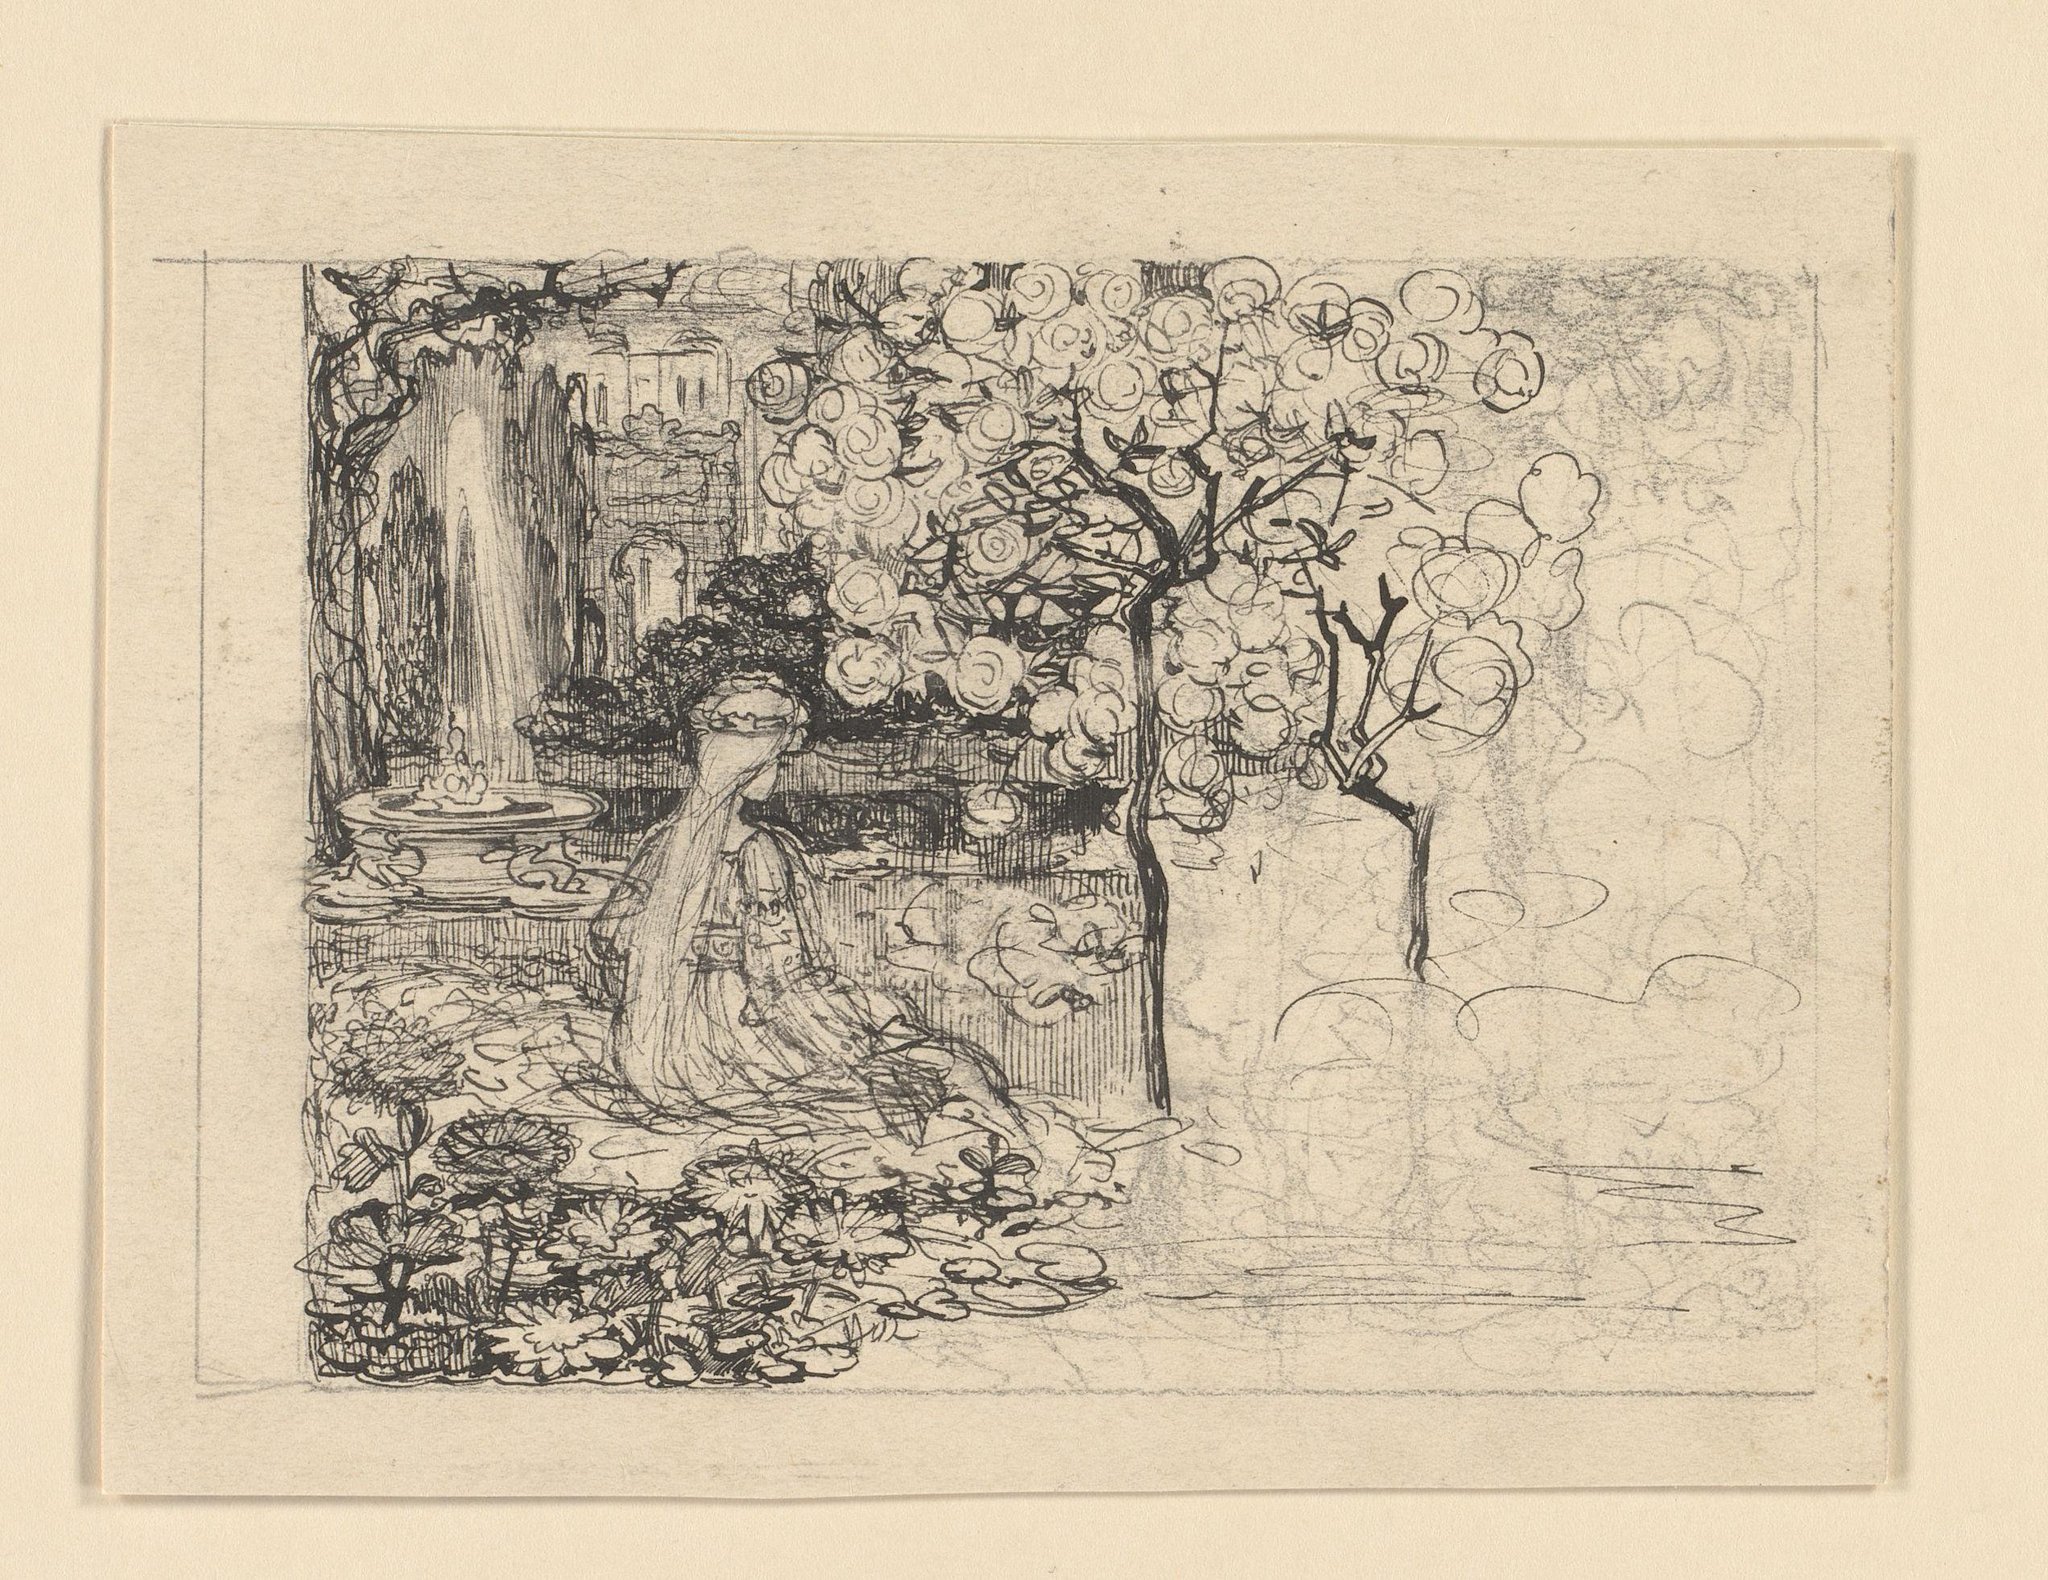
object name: drawing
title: Ella omringd door planten, met op de achtergrond een fontein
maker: edzard koning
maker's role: draughtsman, print maker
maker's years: 1869-1954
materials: ink, paper, pencil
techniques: pen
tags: flowers, (snellen, ella in het feeënrijk) specific works of literature (with author, title), garden fountain, child (at home) - aa - girl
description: Ontwerp voor: Snellen, Agatha. Ella in het Feeënrijk. Amsterdam: C.A.J. van Dishoeck, 1902.